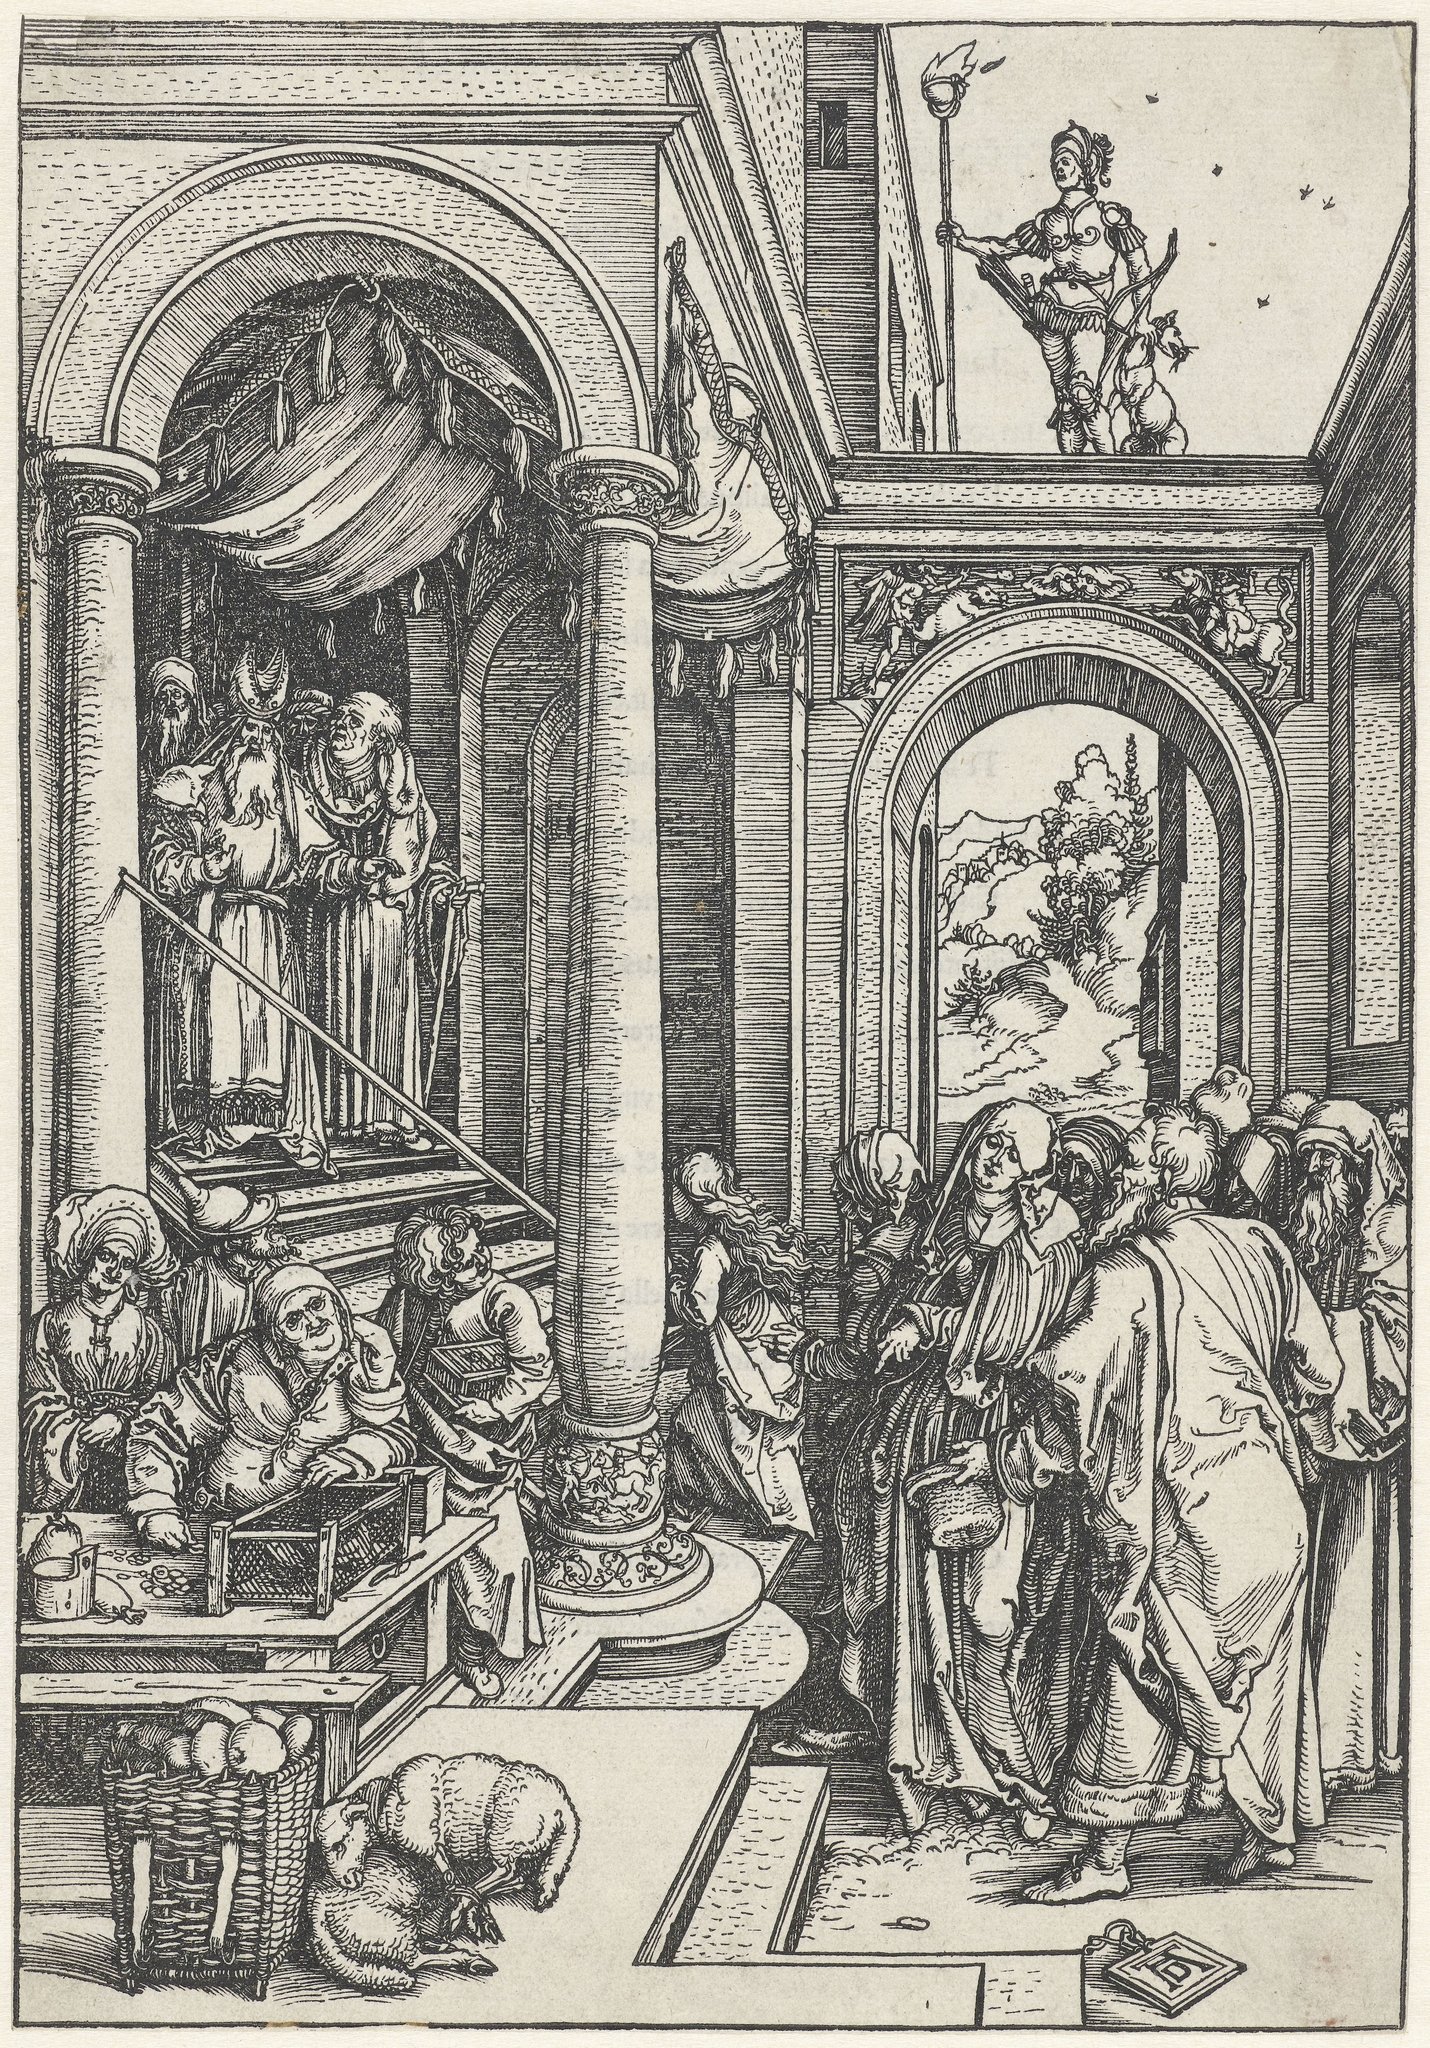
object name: print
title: Presentatie van Maria in de tempel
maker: albrecht dürer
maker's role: draughtsman, painter, print maker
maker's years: 1471-1528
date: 1501-1505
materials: paper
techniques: letterpress printing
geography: nuremberg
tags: dedication (or presentation) of mary in the temple: she ascends the steps and is received by the high priest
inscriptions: collector's mark: Lugt 240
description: Joachim en Anna brengen Maria naar de tempel; het kleine meisje rent de trappen op naar de hogepriester. Op versozijde gedrukte Latijnse tekst. Deze prent is onderdeel van een serie van 20 prenten, bestaand uit een titelprent en 19 prenten met scènes uit het leven van Maria.